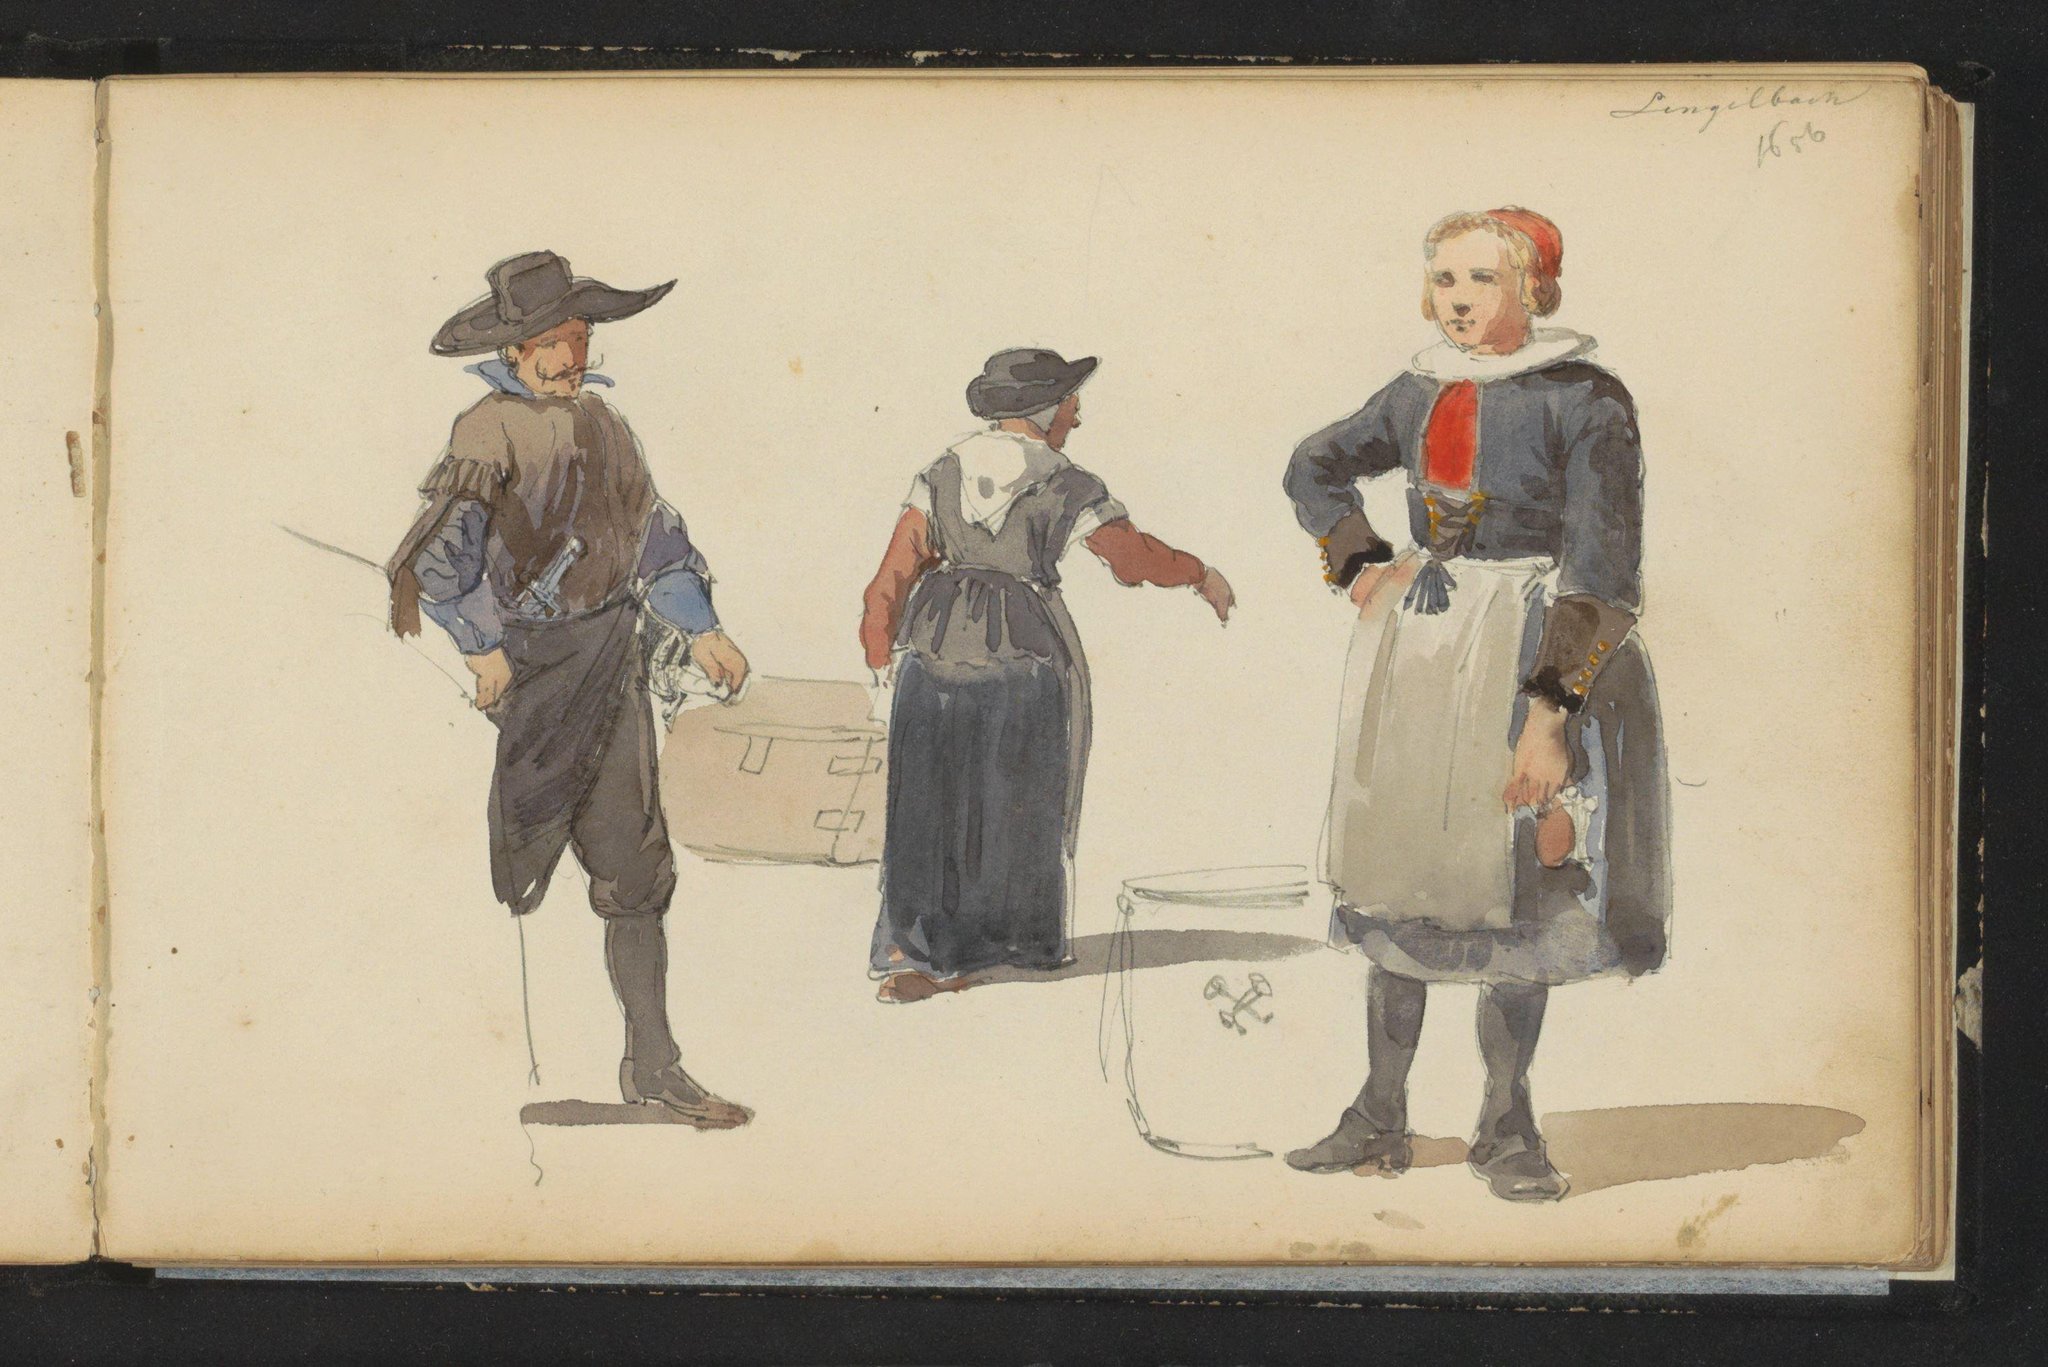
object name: sketchbook leaf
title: Figuren in zeventiende-eeuwse kleding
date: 1846-1882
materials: paper, pencil, watercolor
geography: amsterdam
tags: adult woman, adult man, clothes, costume (+ women's clothes), clothes, costume (+ men's clothes)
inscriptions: annotation: ‘Lingelbach 1656’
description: Twee vrouwen en een man in zeventiende-eeuwse kleding. Blad 23 uit een schetsboek met 91 bladen.